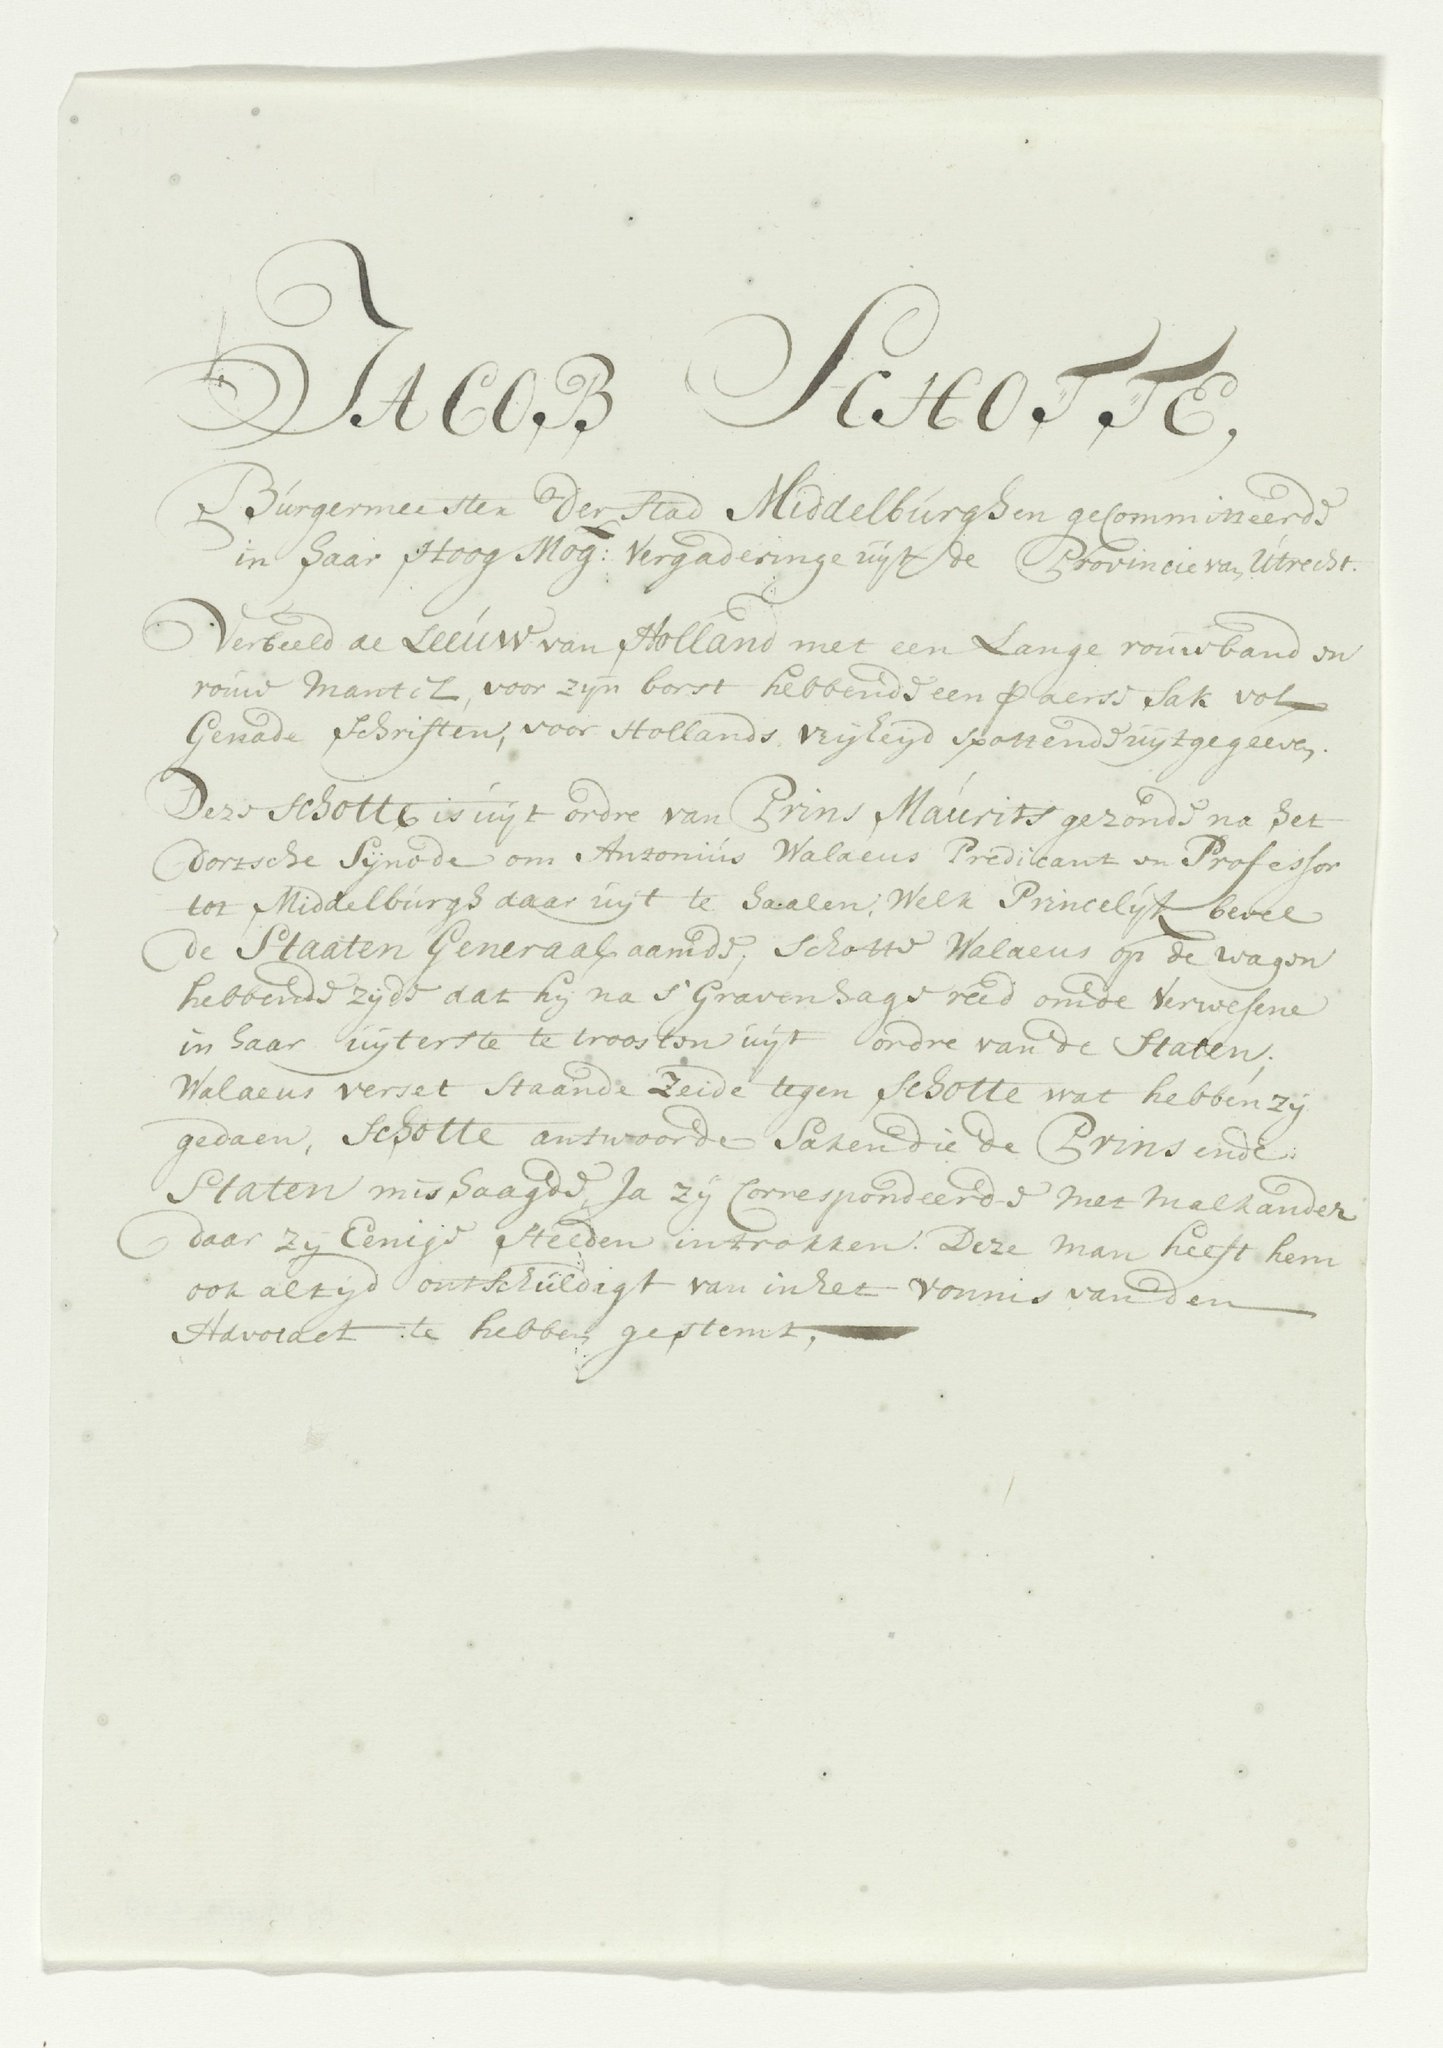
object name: poem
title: Regtspleging van Oldenbarnevelt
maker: Anonymous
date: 1710-1720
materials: paper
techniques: pen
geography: netherlands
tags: the hague, johan van oldenbarnevelt, middelburg, mayor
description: Spotprent van Jacob Scotte, rechter van Van Oldenbarnevelt; leeuw met zwarte mantel, waarop wapen, en hoed.Om midden wapen. In rechterpoot een brief warop 'GENADE' staat. In krans van bloemen en bladeren. Daaronder cartouche waarin naam en daarboven nr. 16. Behorende bij serie aquarellen in boek.